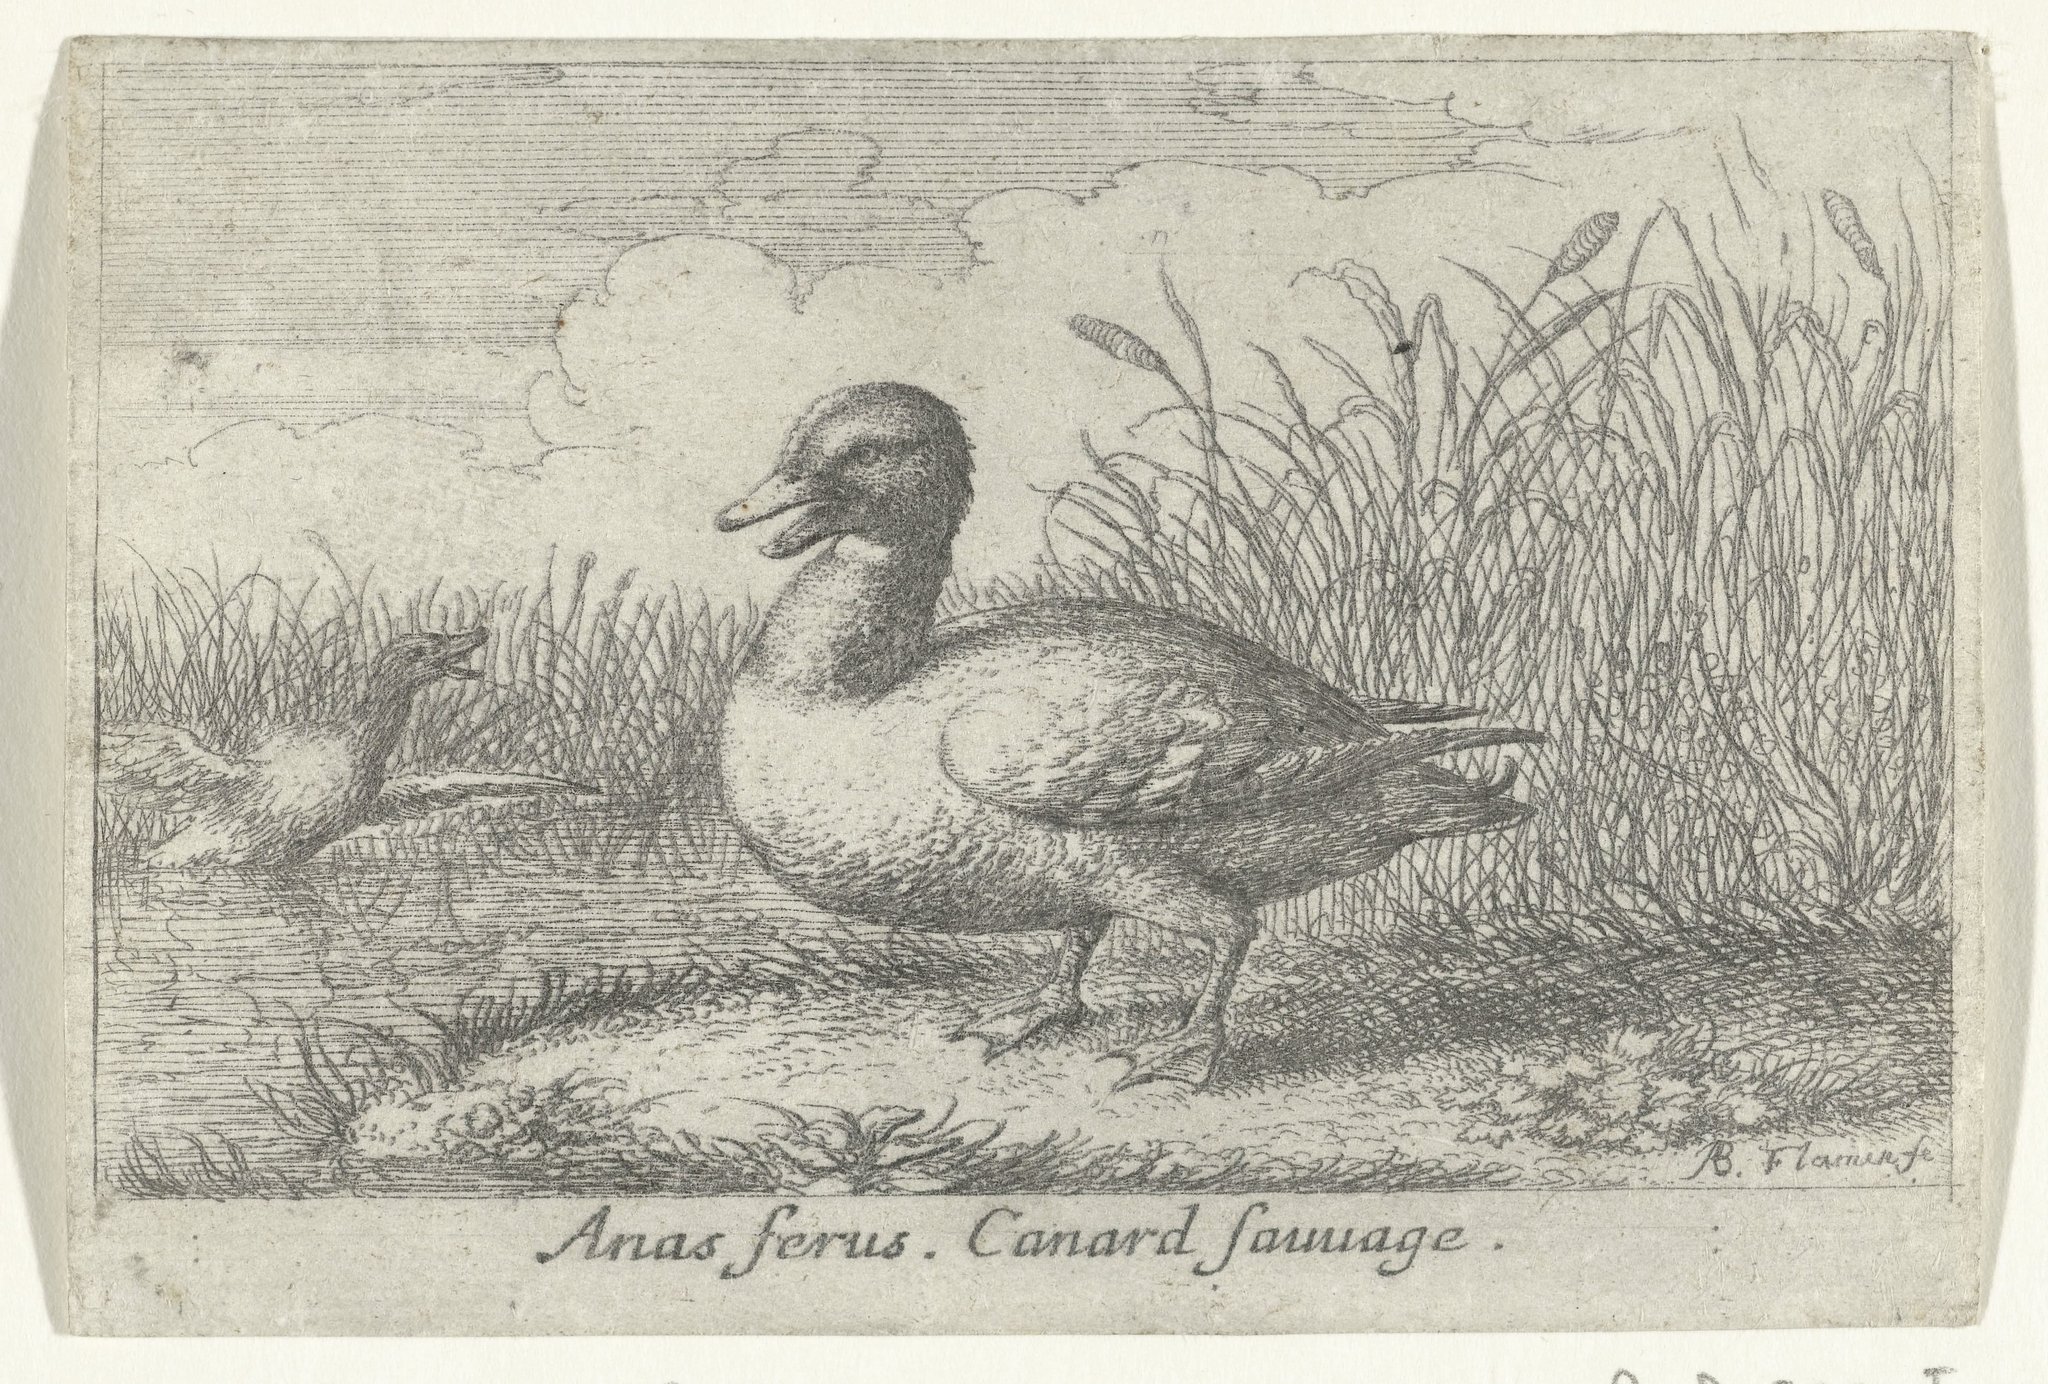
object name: print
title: Dertien vogelsoorten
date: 1659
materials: paper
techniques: etching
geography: paris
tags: water-birds: duck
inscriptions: collector's mark: Lugt 2228